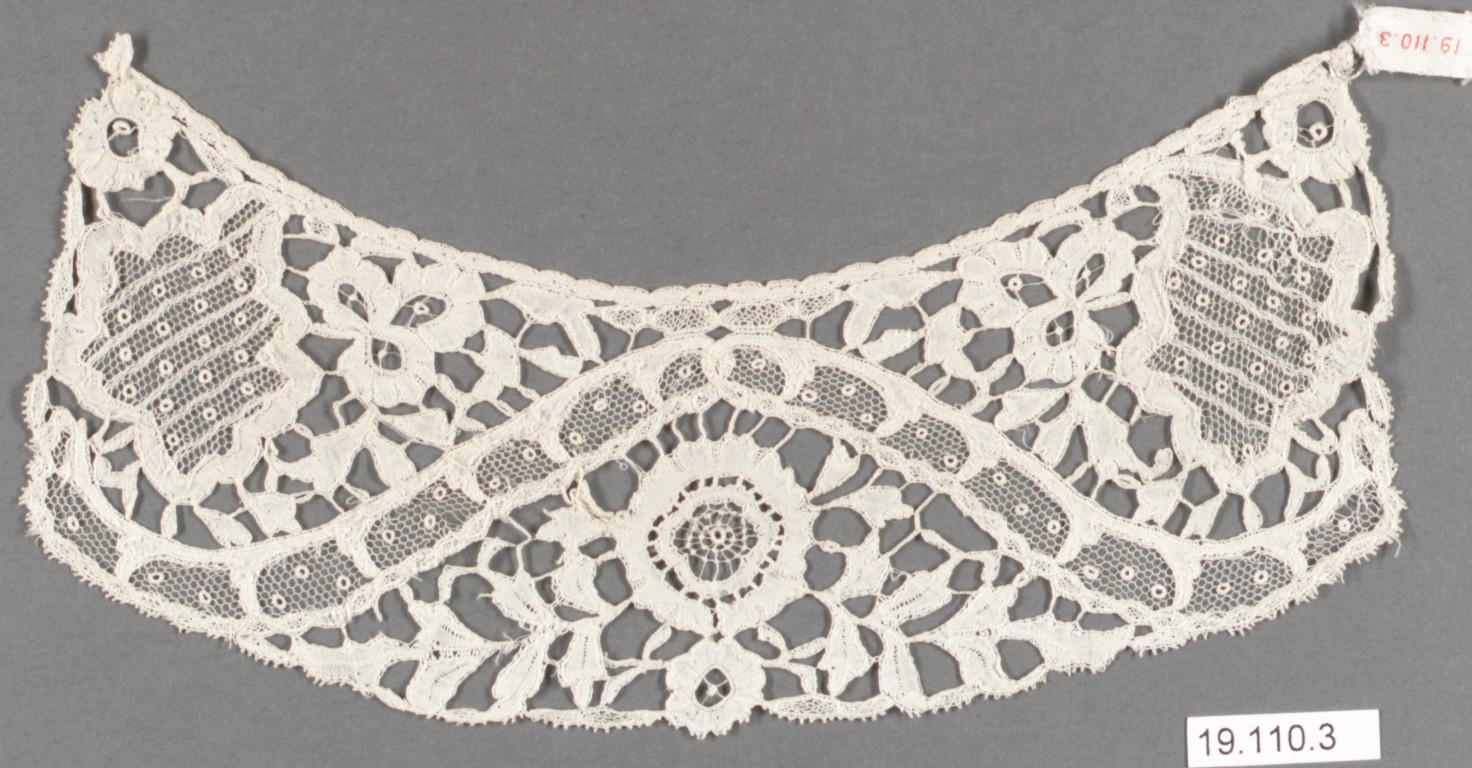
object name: cuff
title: Cuffs (2)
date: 1801-1900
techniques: lace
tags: flowers